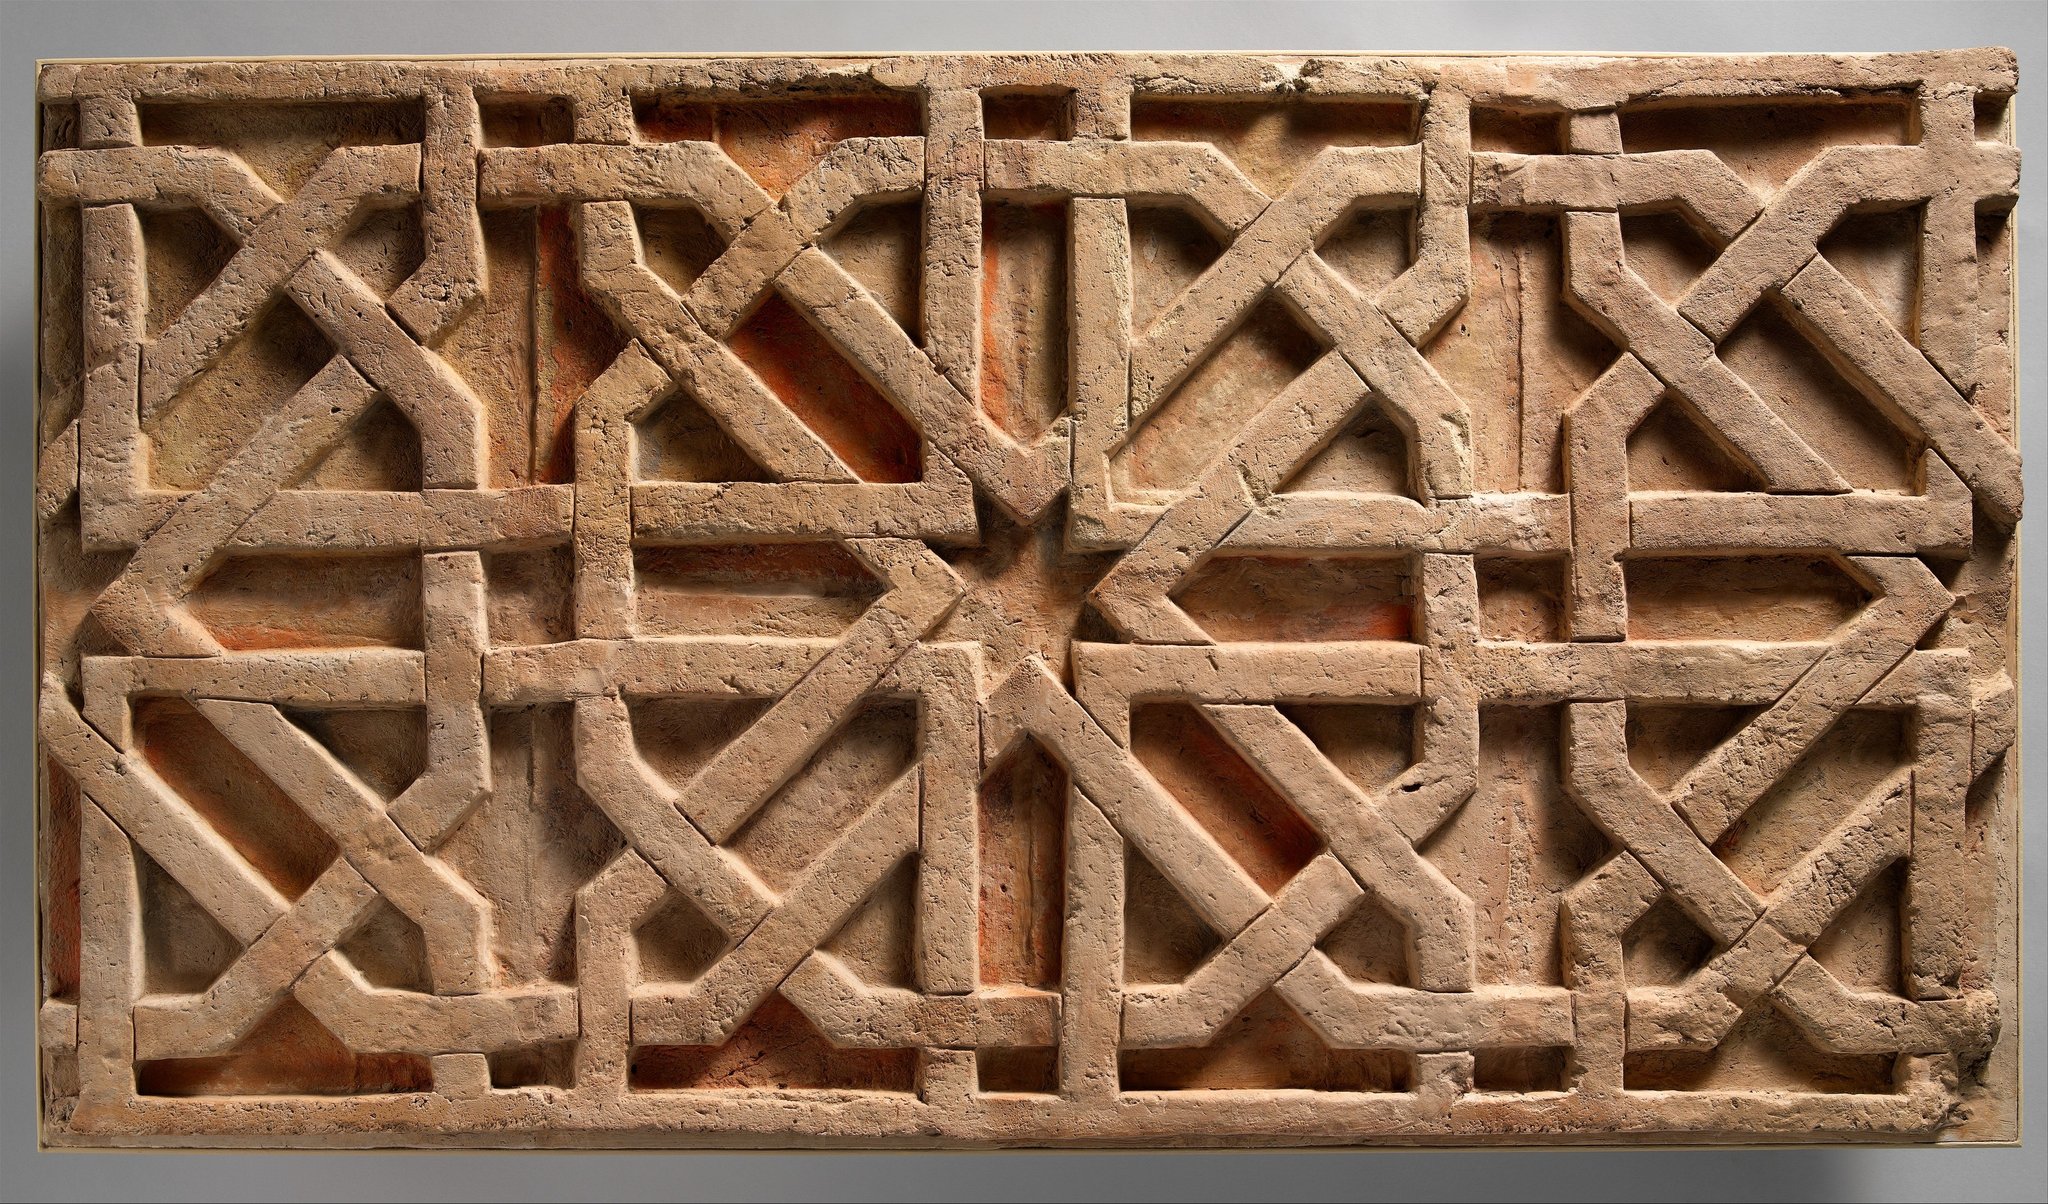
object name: frieze fragment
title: Fragment of a Frieze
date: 1001-1100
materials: terracotta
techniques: carving, painting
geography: iran